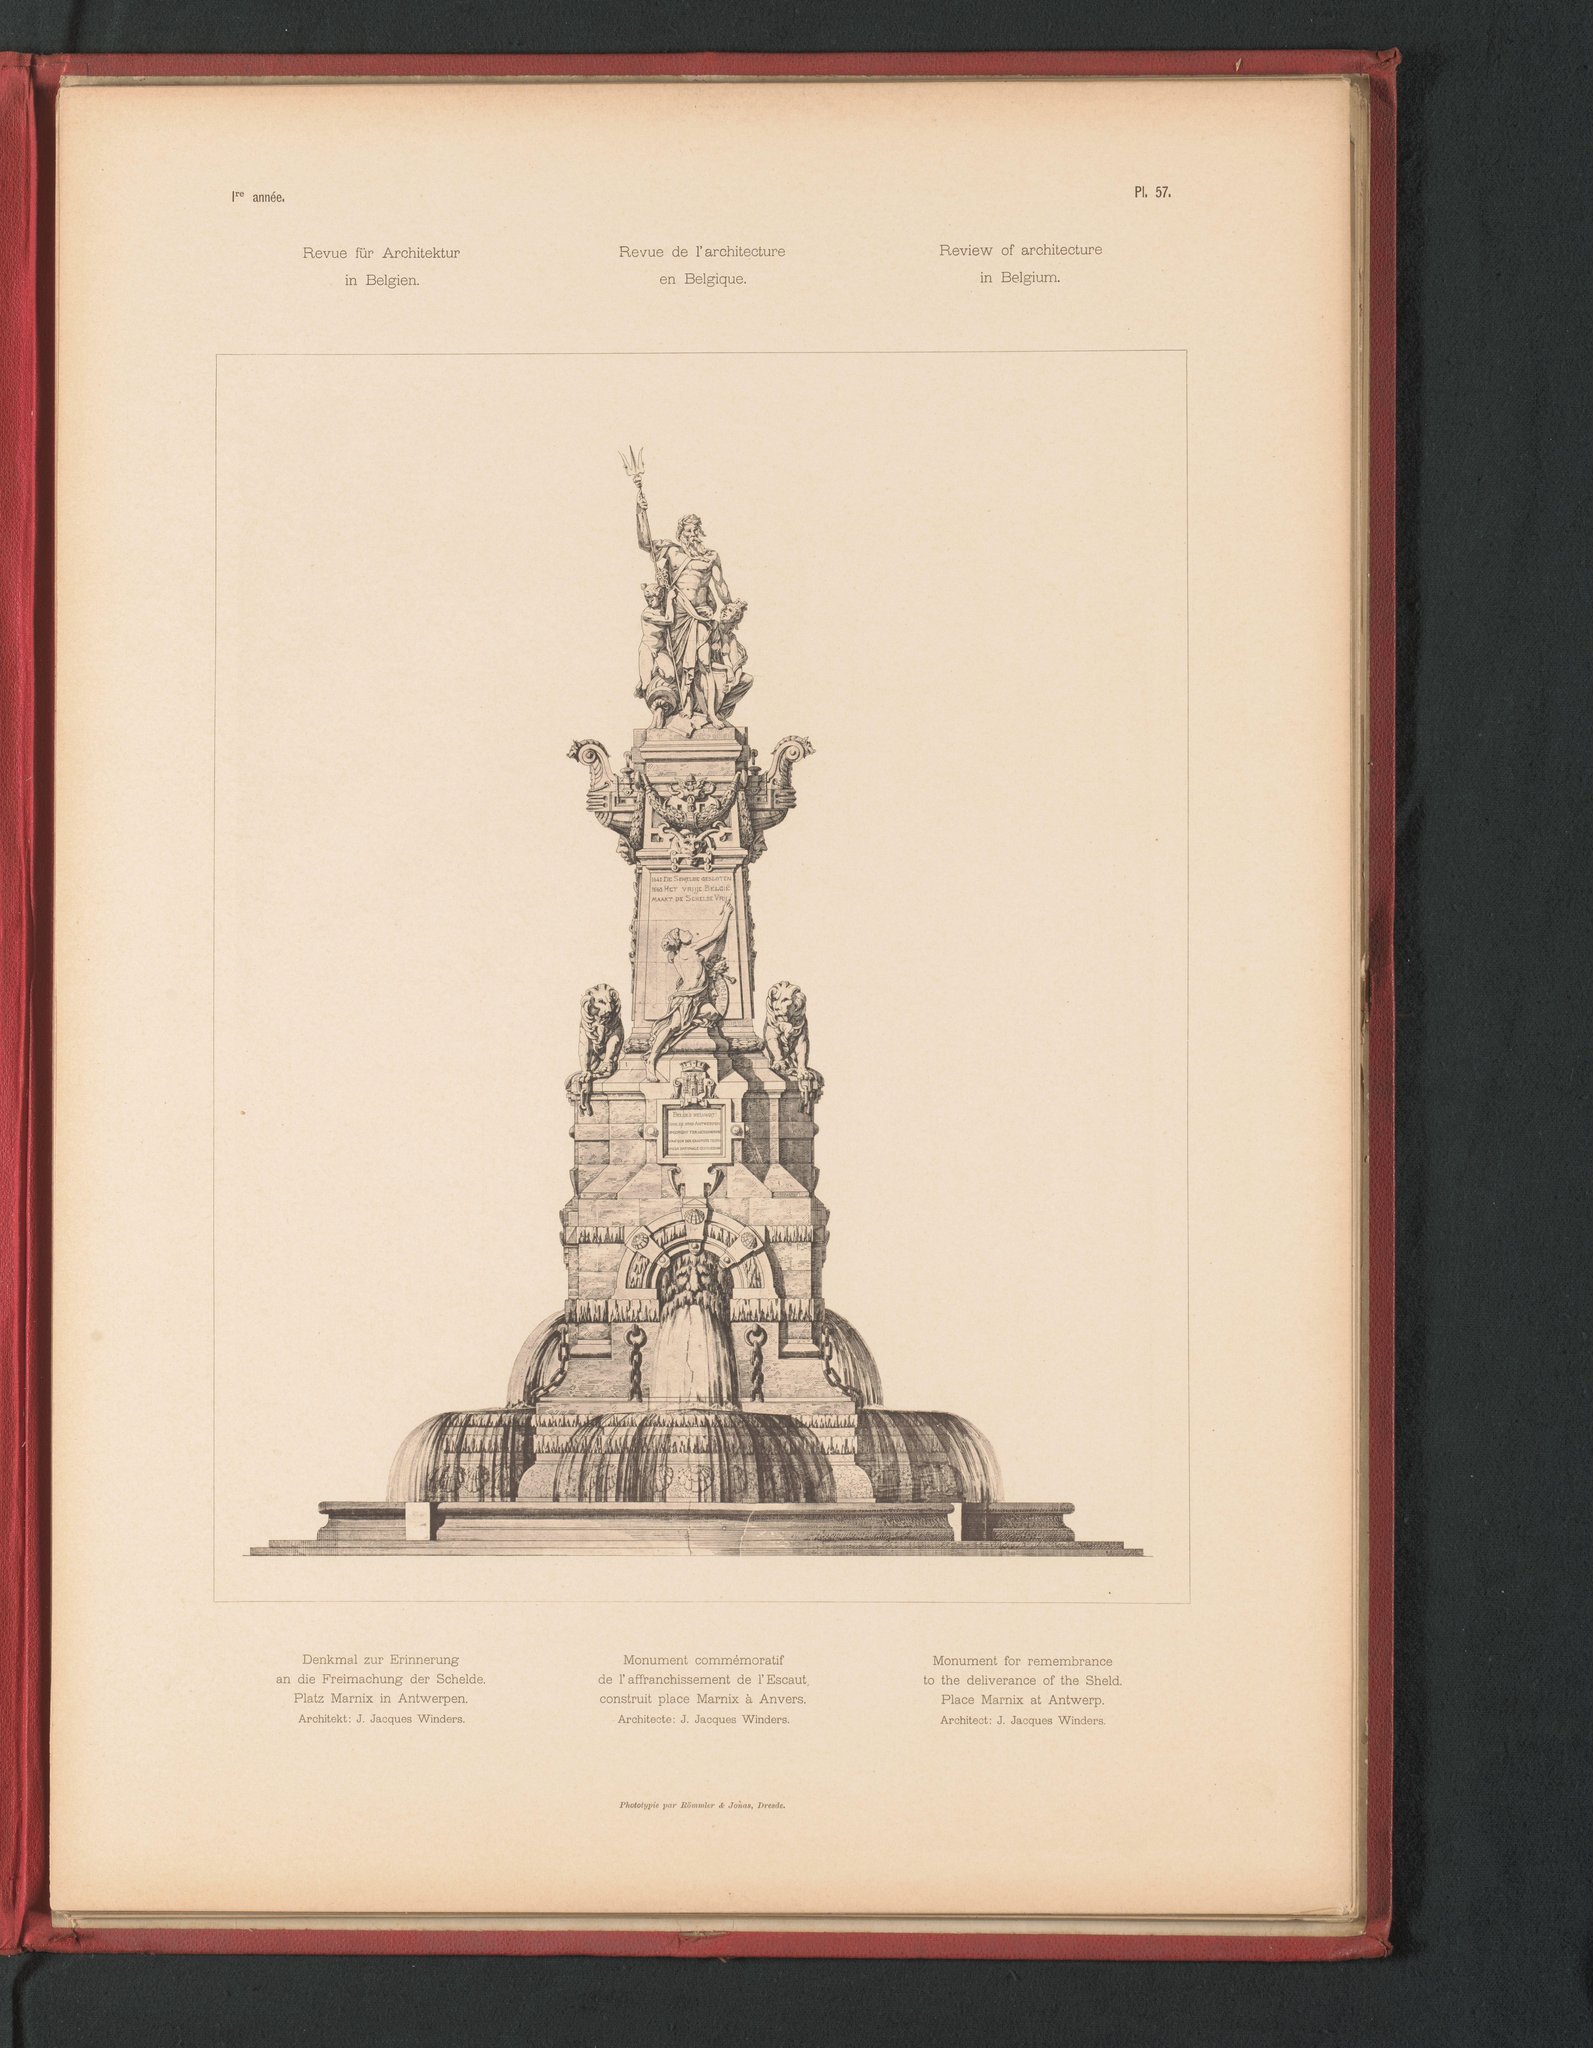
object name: reproduction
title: Reproductie van een ontwerp van een monument voor de vrijmaking van de Schelde, door Jean-Jacques Winders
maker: jean-jacques winders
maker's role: architect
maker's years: 1849-1936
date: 1888-1893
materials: paper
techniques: photograph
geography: dresden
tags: monument, statue, exterior ~ architectural design or model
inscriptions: number: ‘Pl. 57.’, inscription: ‘1re. annèe.’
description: Deze prent maakt deel uit van een omslag met 110 prenten op 90 bladen en 18 tekstbladen.